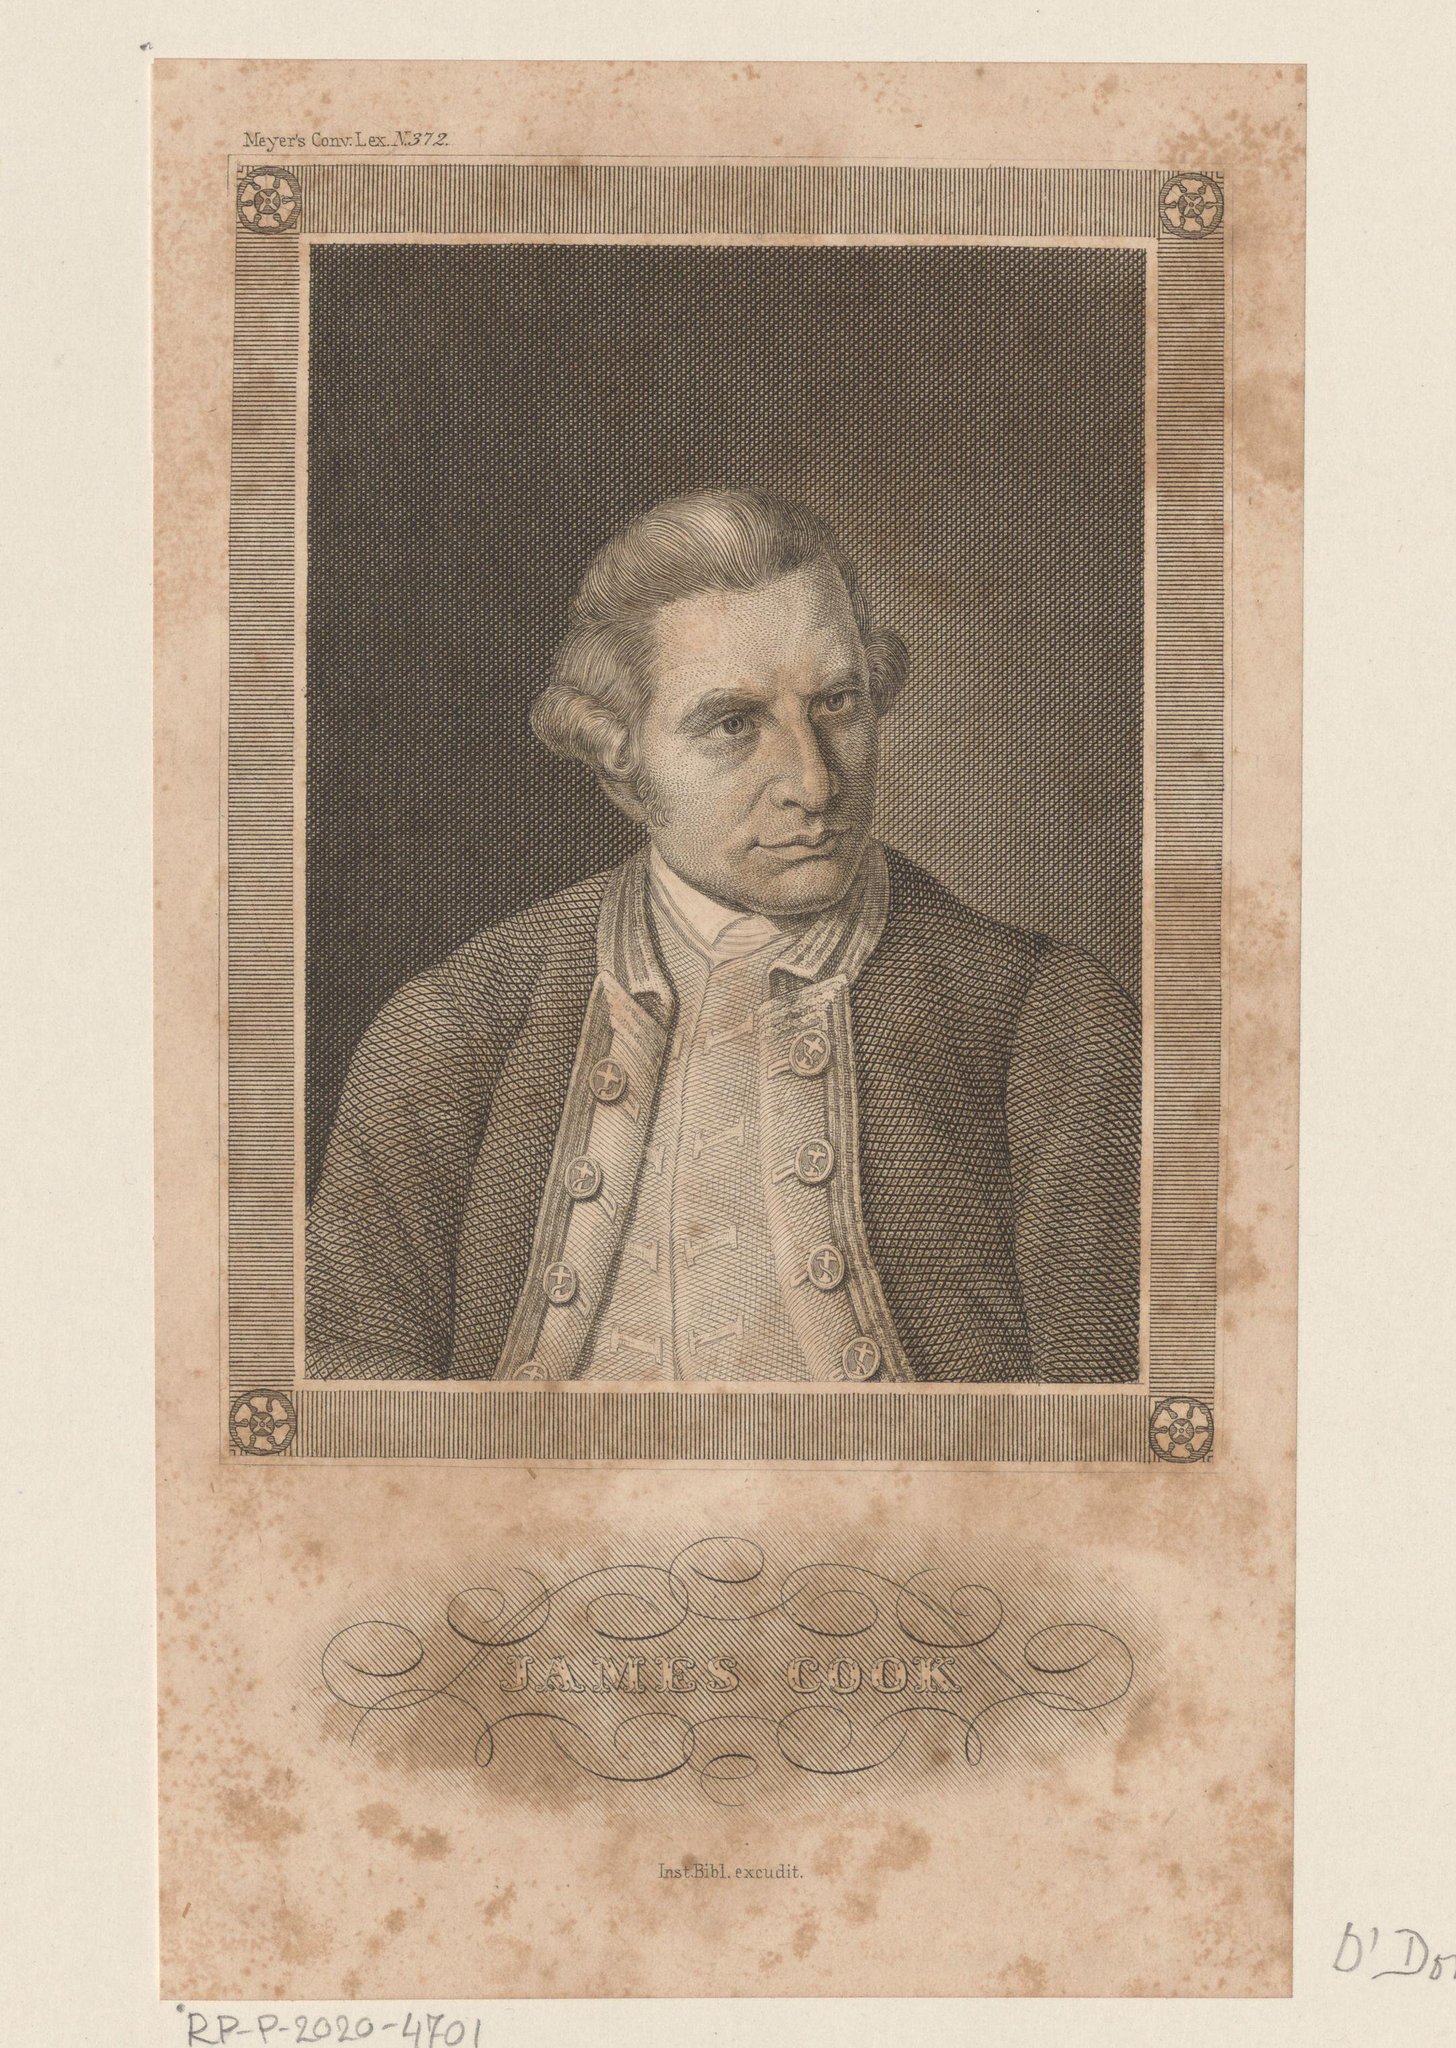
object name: print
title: Portret van James Cook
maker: Anonymous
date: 1839-1855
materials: paper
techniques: etching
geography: hildburghausen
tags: james cook, historical persons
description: Prent mogelijk uit: Meyer, Joseph. Conversations-Lexikon für die gebildeten Stände. Hildburghausen: Bibliographisches Institut, 1839-1855.